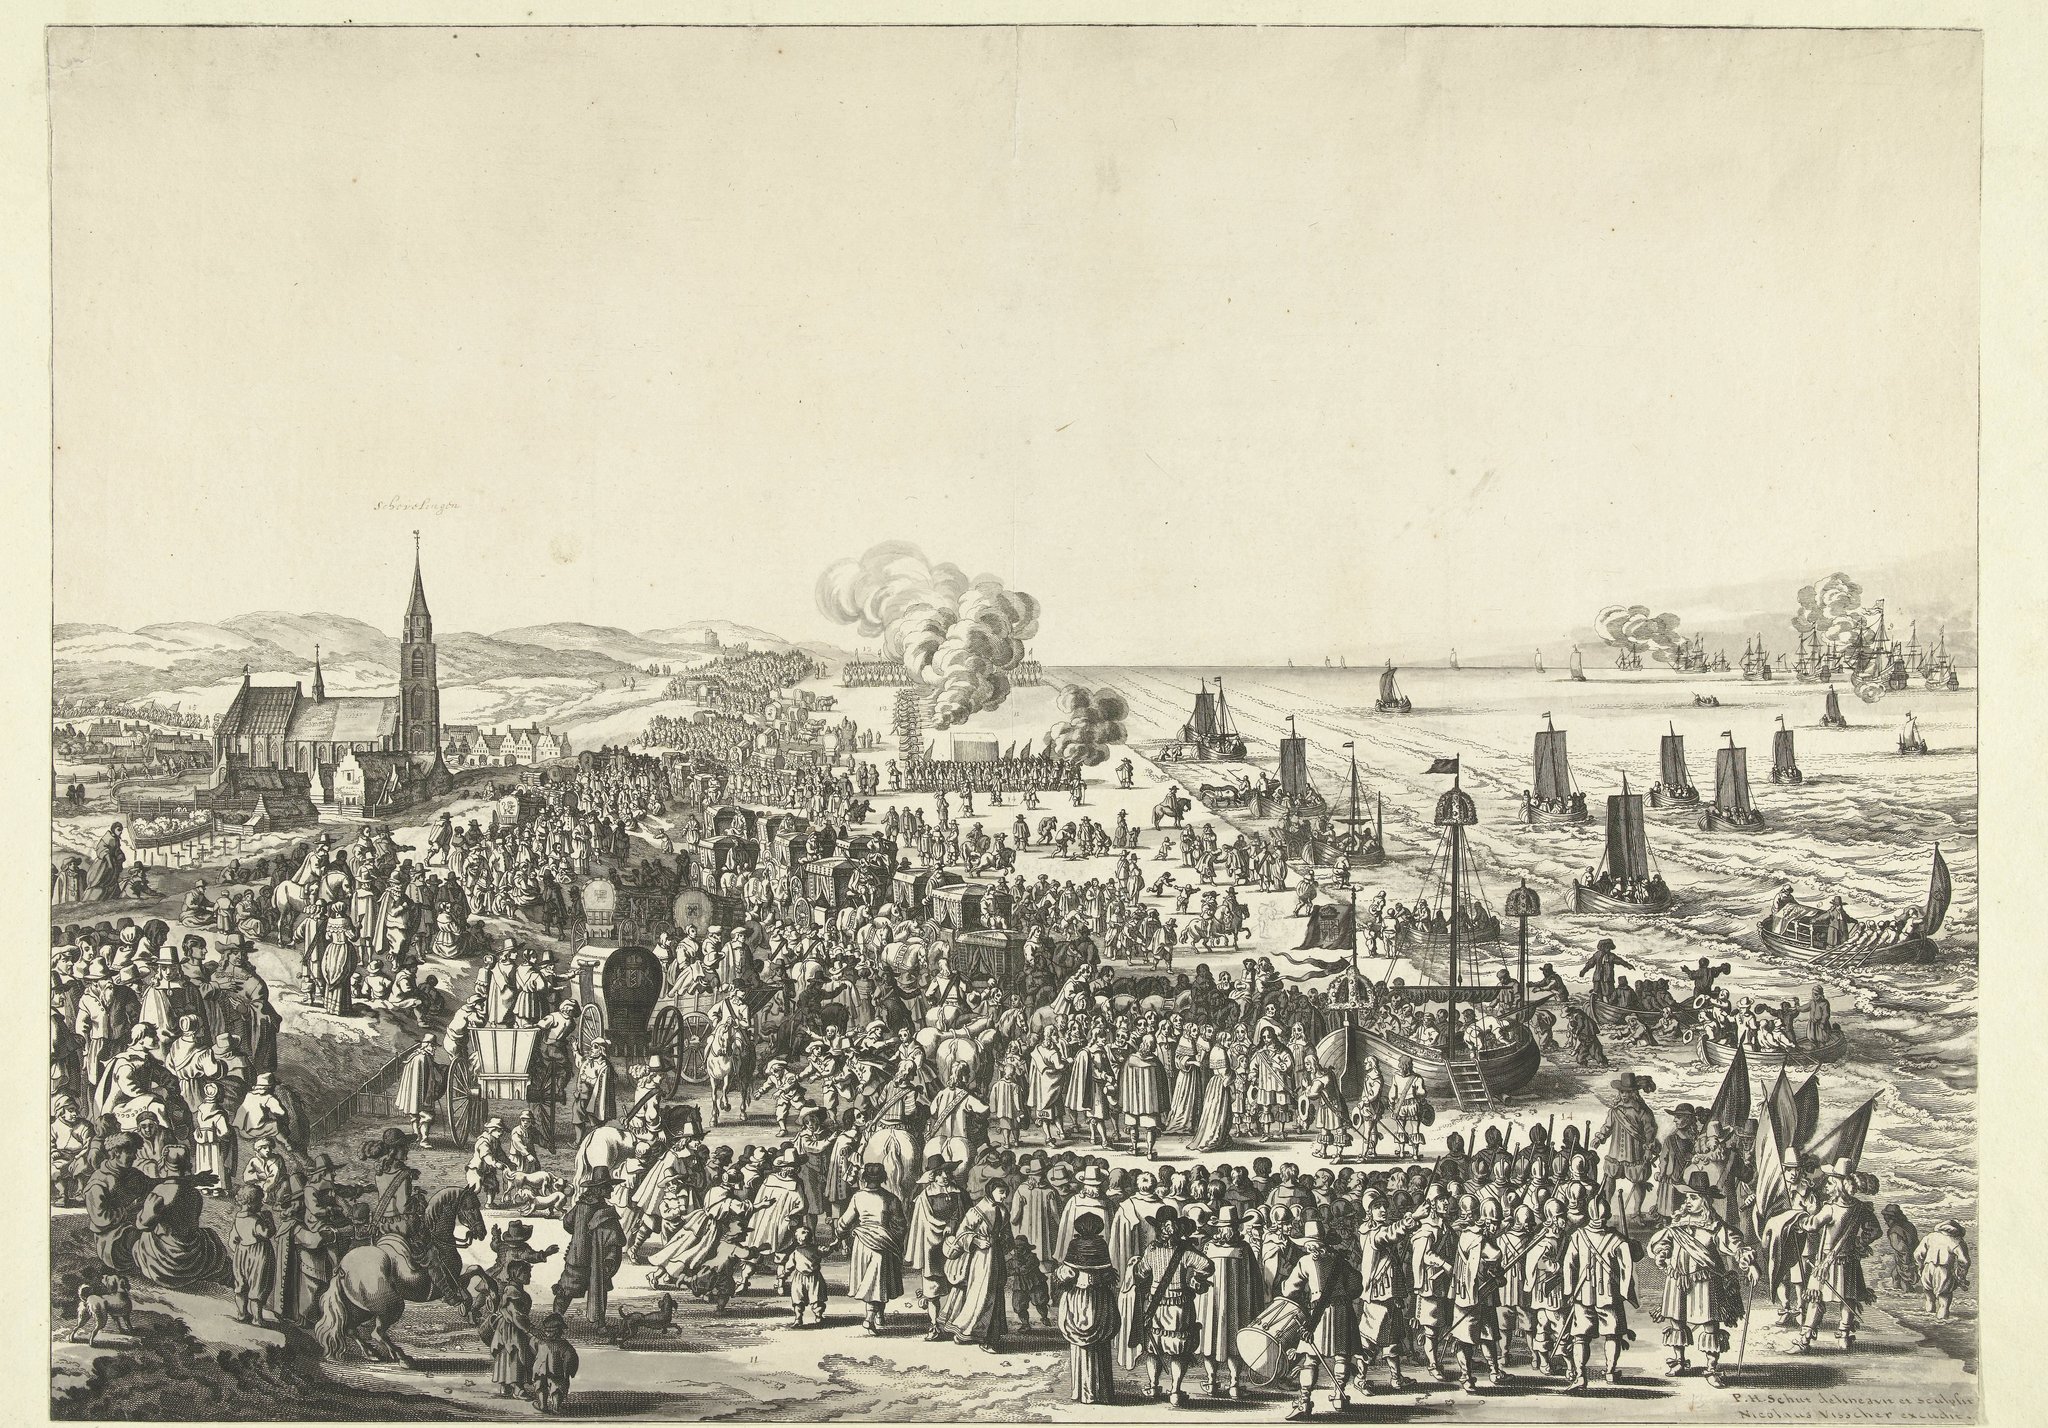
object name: print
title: Vertrek van Karel II uit Scheveningen naar Engeland, 1660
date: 1660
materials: ink, paper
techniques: brush, engraving, etching, pen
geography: amsterdam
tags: karel ii (koning van engeland), departure ~ travelling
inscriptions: inscription: ‘P.H. Schut delineavit en sculpsit - Nicolaus Visscher excudit’, collector's mark: Lugt 2228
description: Het vertrek van de Engelse koning Karel II vanuit Scheveningen naar Engeland, 2 juni 1660. Op het strand een menigte van toeschouwers, in het midden neemt Karel afscheid van zijn zuster en tante. Links koetsen, de duinen en het dorp Scheveningen, op de achtergrond vuren kanonnen saluutschoten. Vóór het portret van Karel II en het onderschrift.